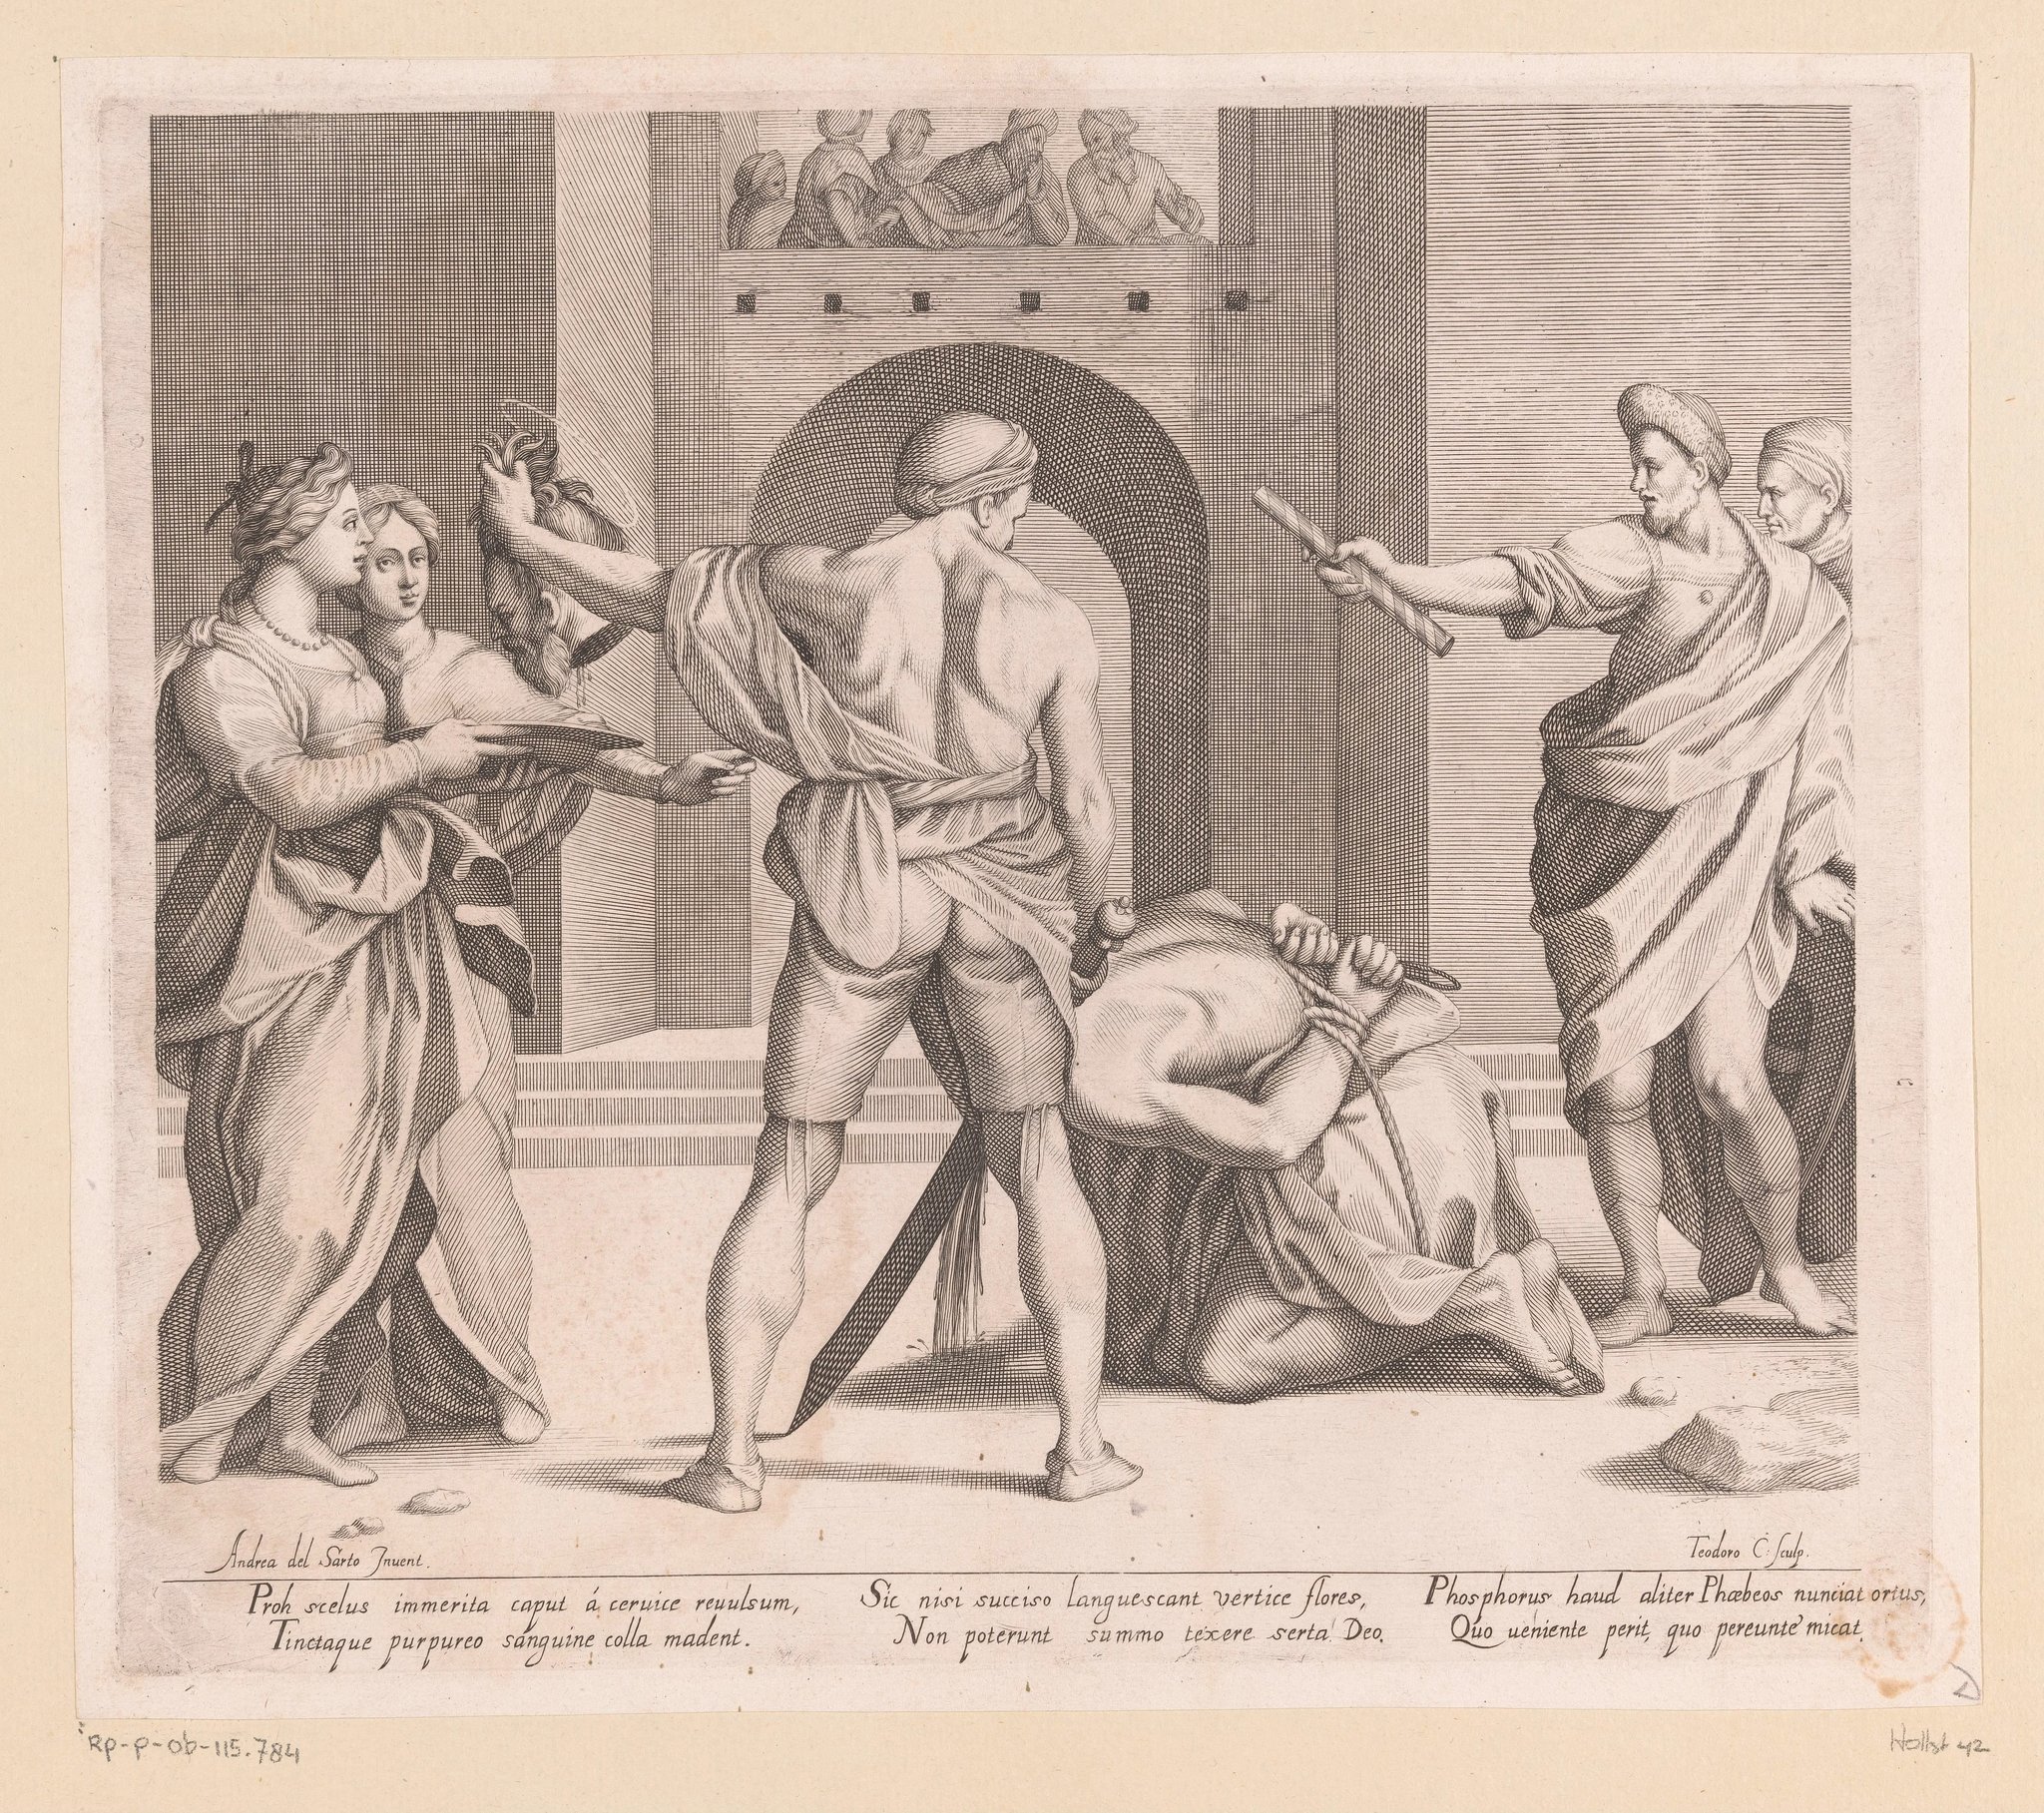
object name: print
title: Vita D. ioannis Baptistae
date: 1617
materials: paper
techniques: engraving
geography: florence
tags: salome is given the head of john the baptist by the executioner, the beheading of john the baptist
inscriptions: collector's mark: Lugt 240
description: Onderdeel van een serie van dertien prenten en een titelprent.